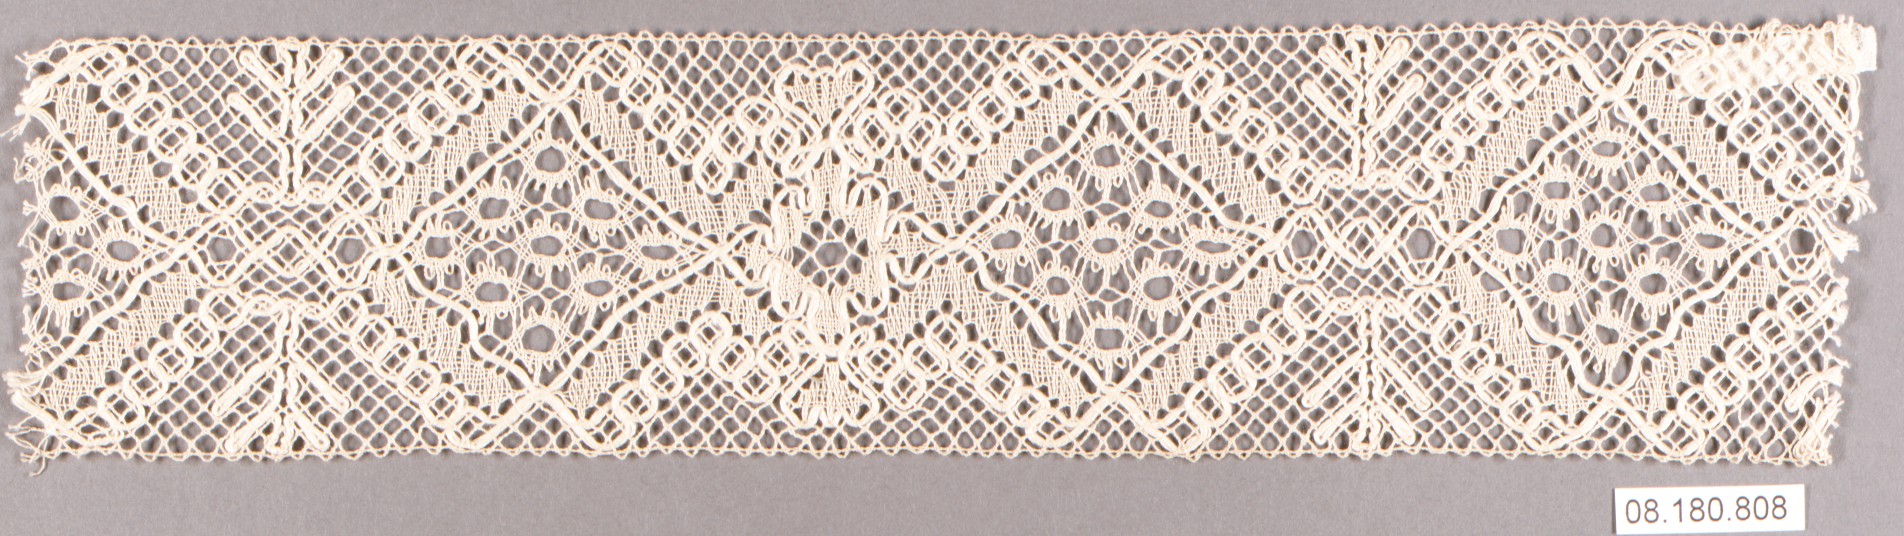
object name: fragment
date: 1801-1900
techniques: lace